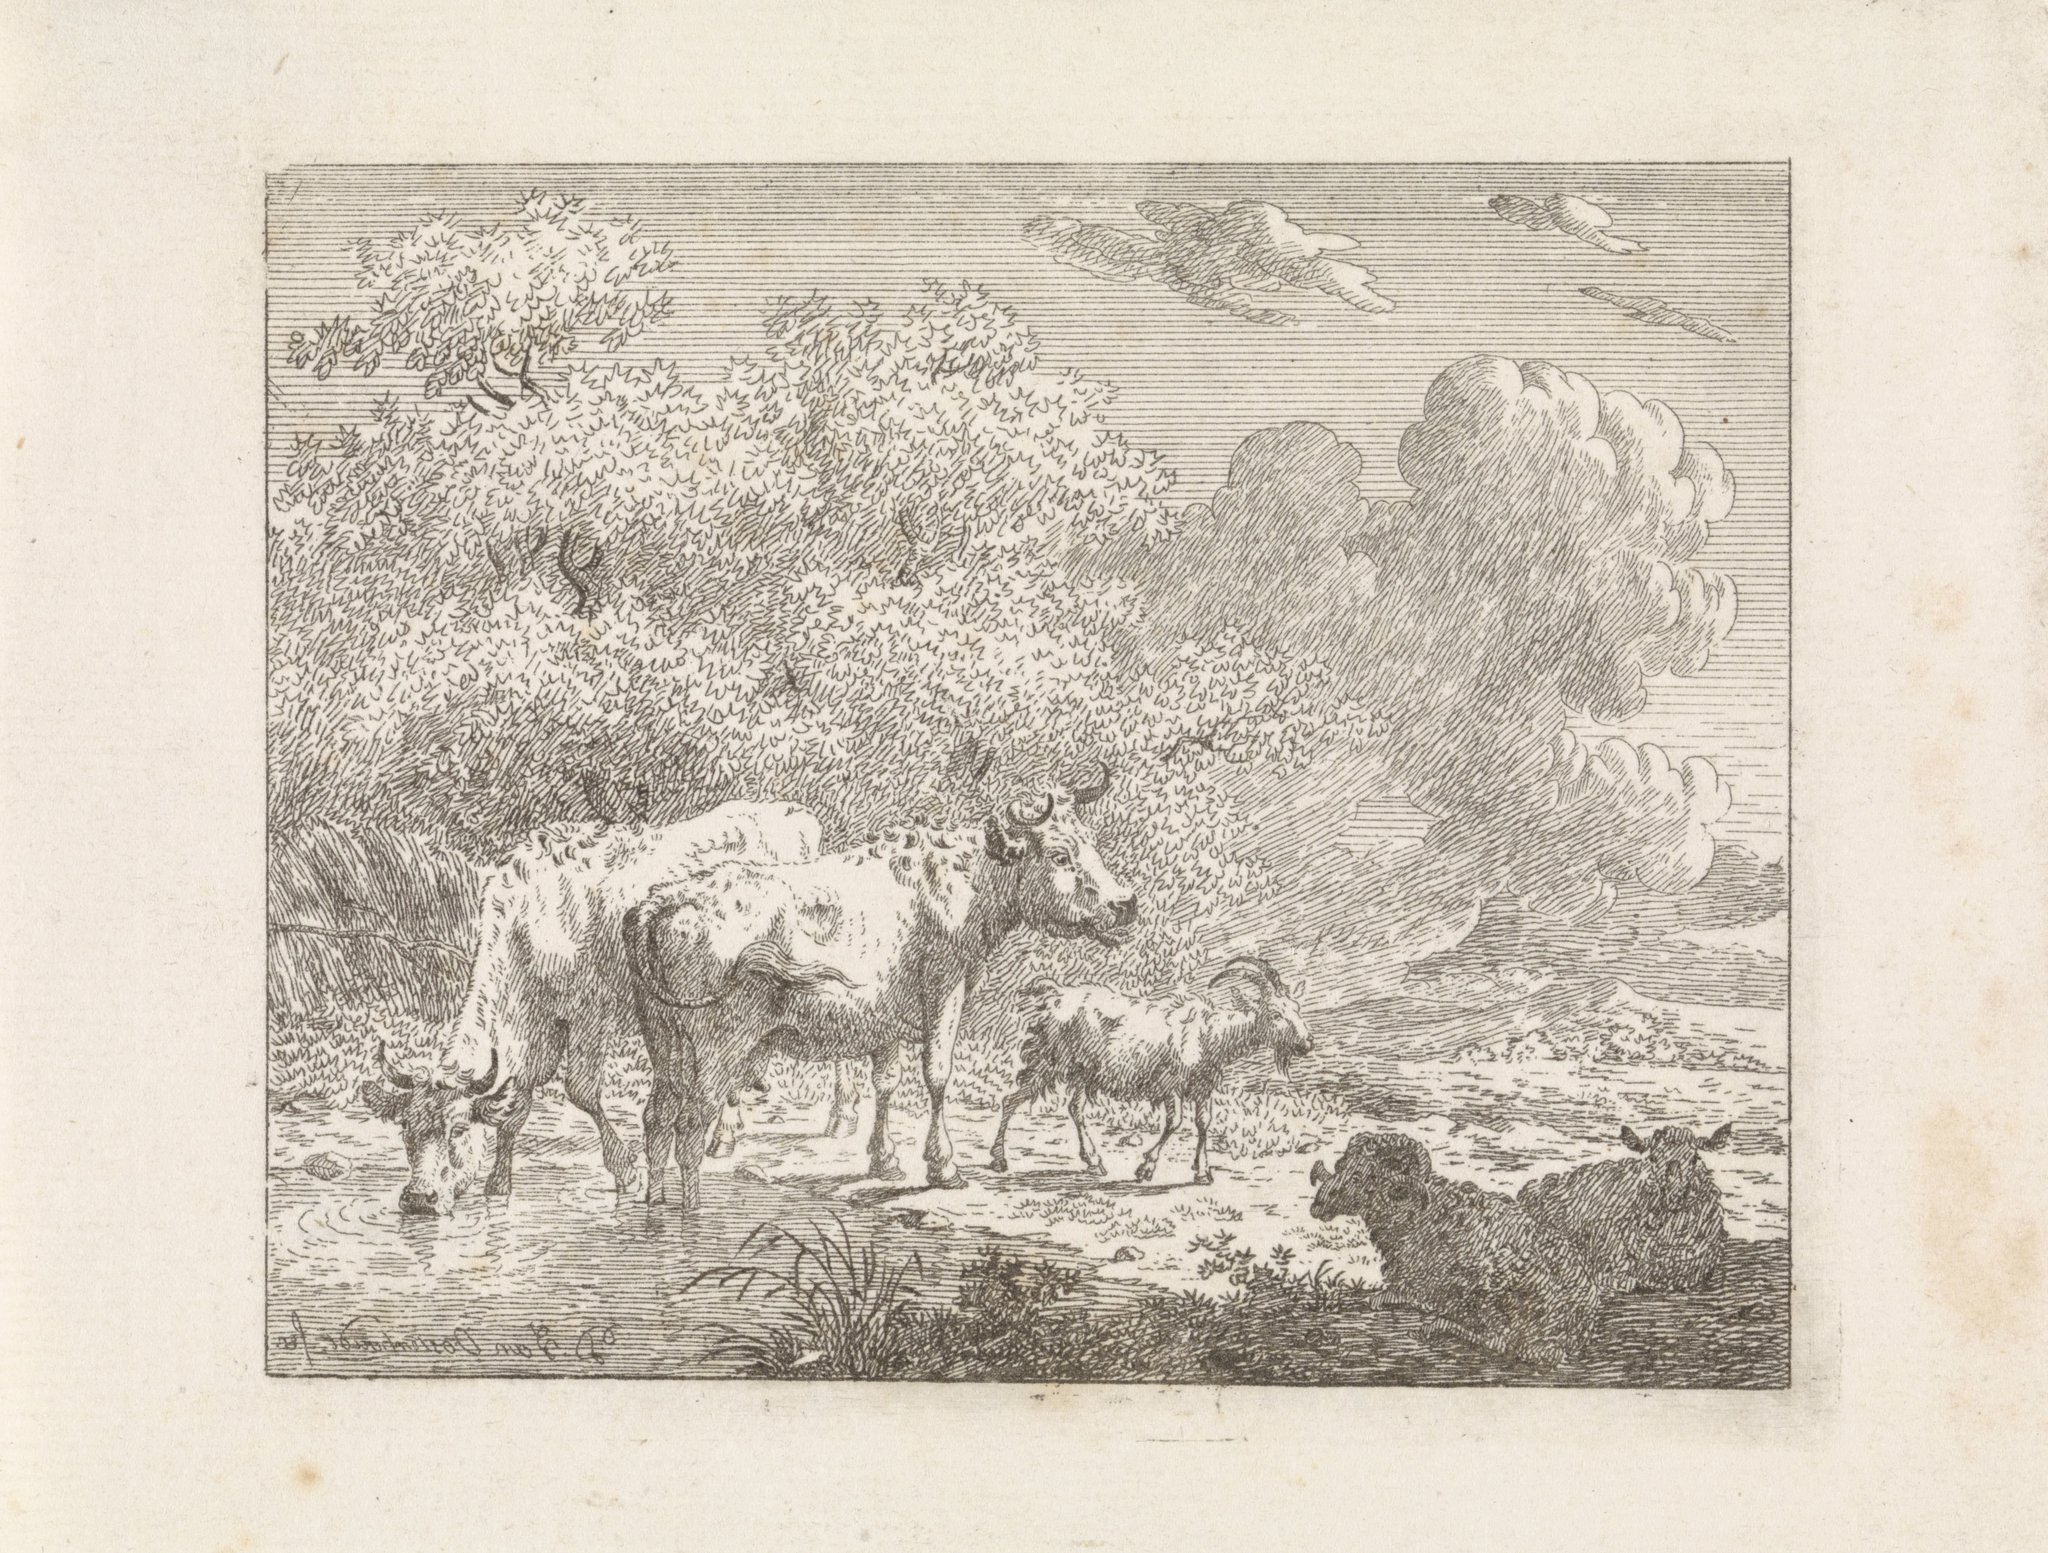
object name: print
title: Landschap met schapen, geit en koeien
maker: dirk van oosterhoudt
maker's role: draughtsman, painter, print maker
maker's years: 1756-1830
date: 1766-1830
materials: paper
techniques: printmaking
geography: tiel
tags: cow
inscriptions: collector's mark: Lugt 1485, collector's mark: Lugt 2228